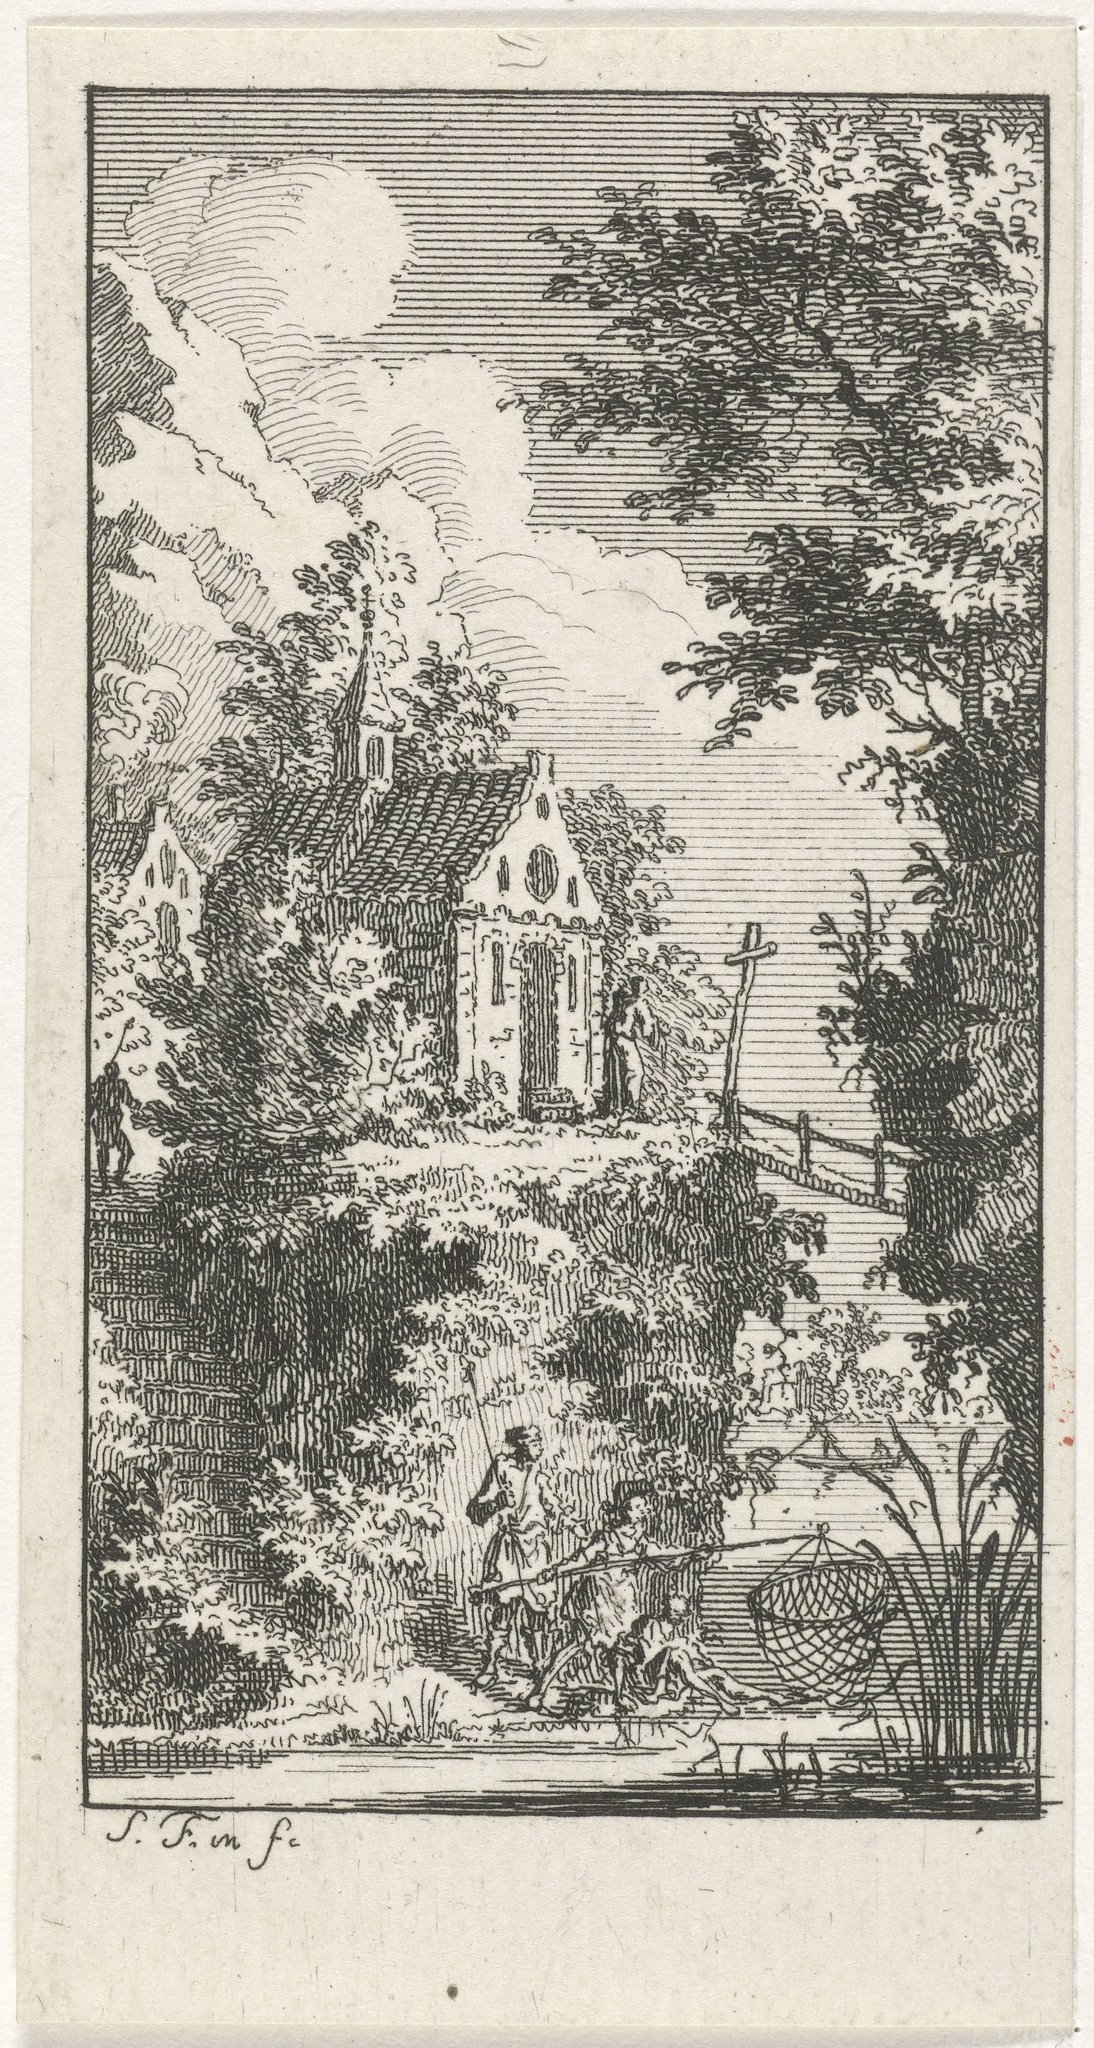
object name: print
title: Augustus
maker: simon fokke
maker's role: draughtsman, print maker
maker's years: 1712-1784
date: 1722-1784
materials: paper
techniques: etching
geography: amsterdam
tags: august ~ other concepts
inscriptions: collector's mark: Lugt 240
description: Uit een serie van twaalf prenten, de verbeelding van de maand augustus. Zicht op een hoog gelegen huis met vissende figuren bij het water.